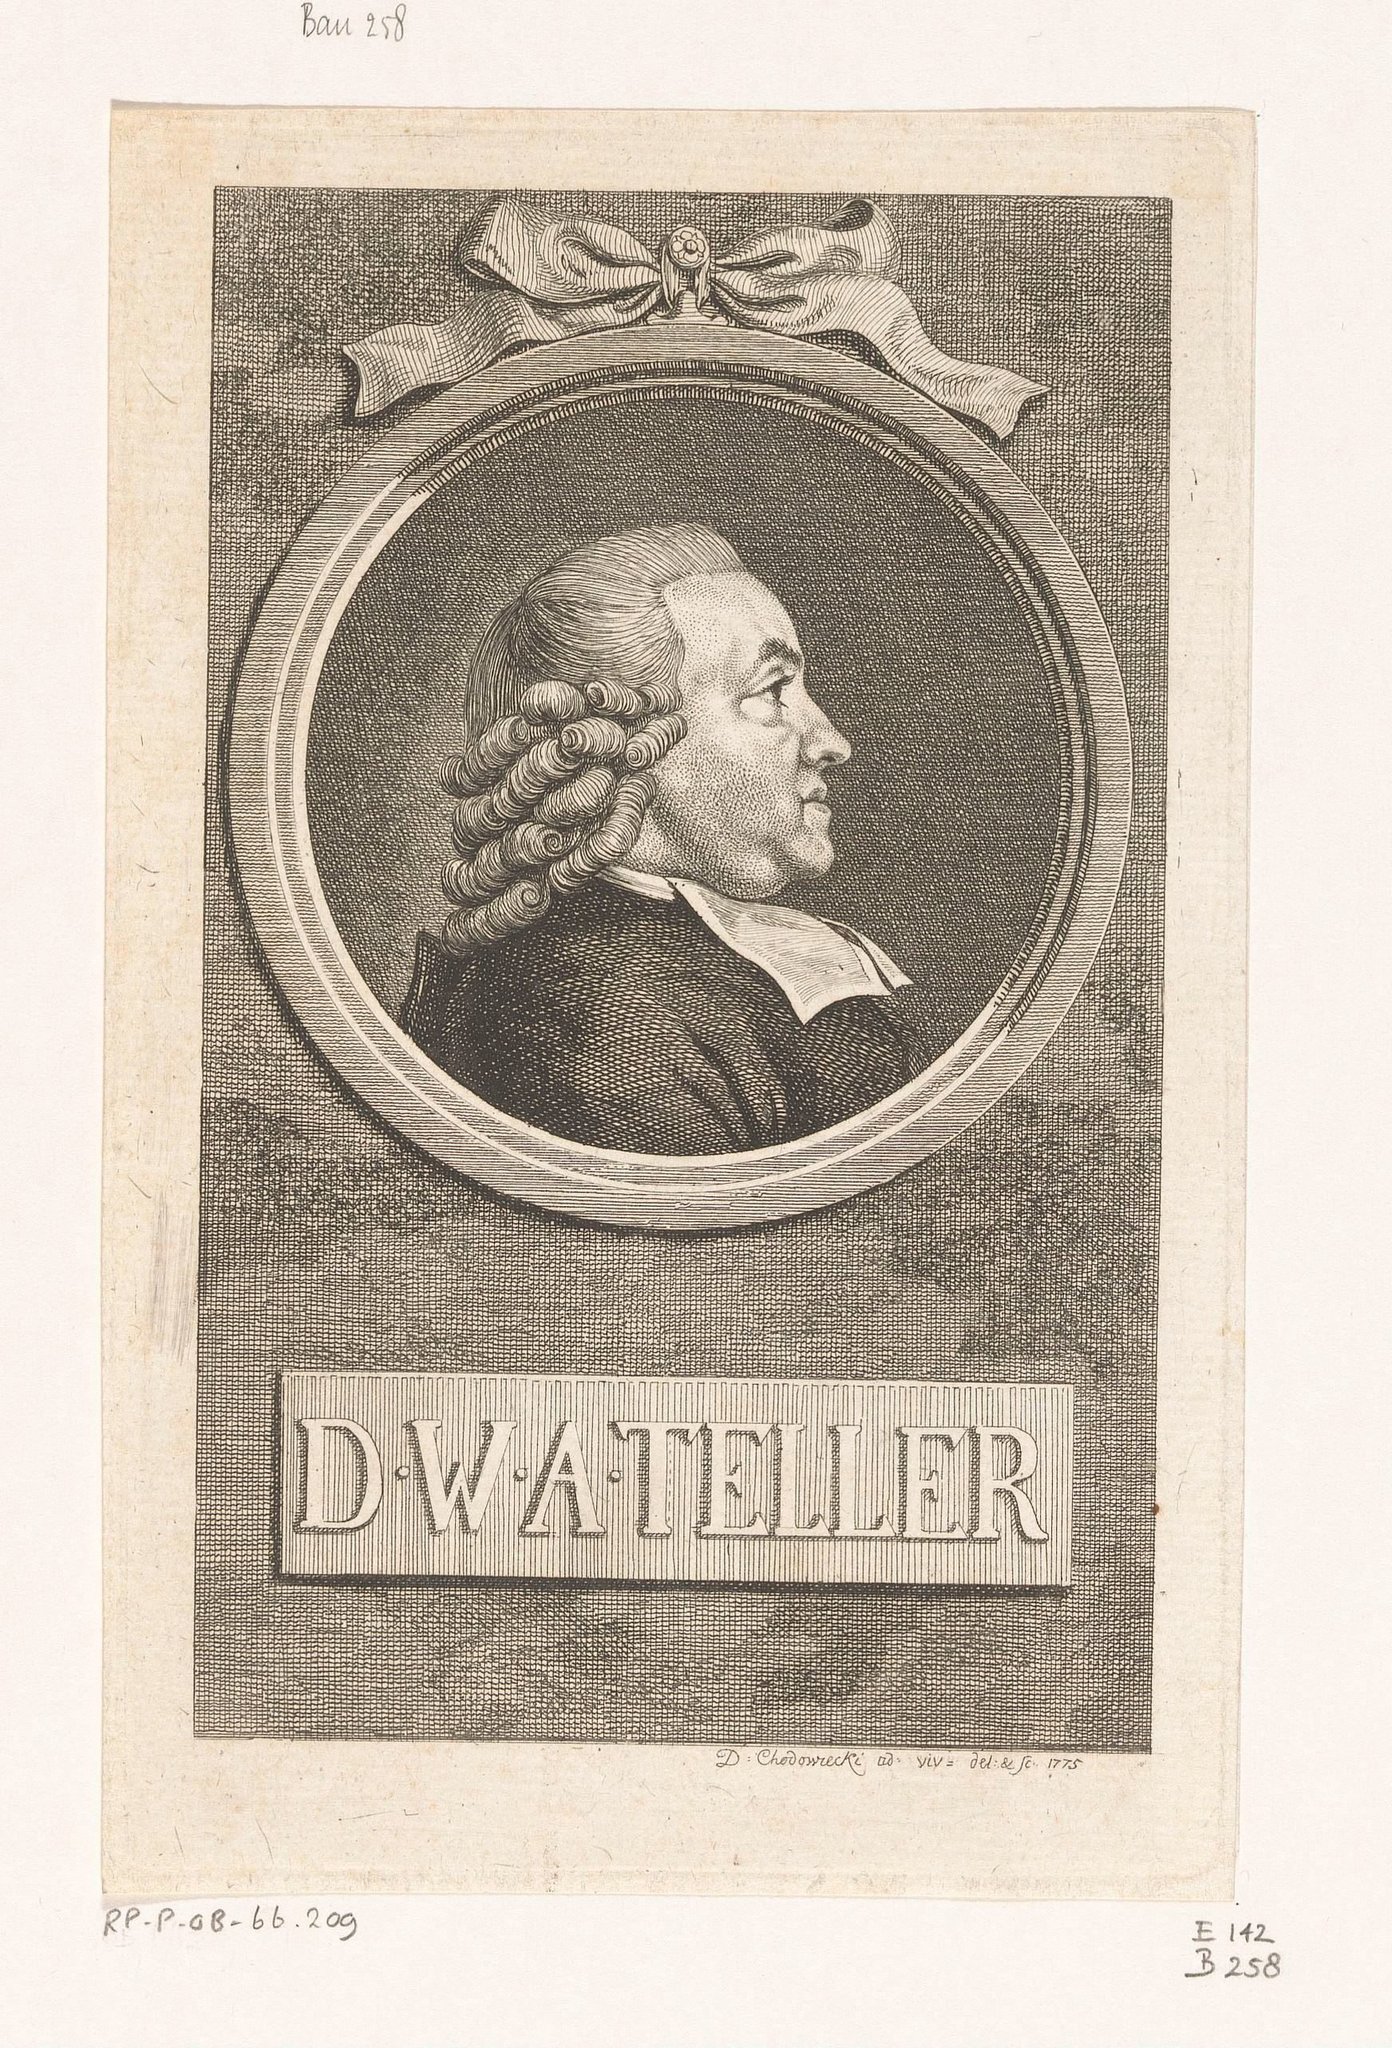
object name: print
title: Portret van Wilhelm Abraham Teller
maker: daniel nikolaus chodowiecki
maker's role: draughtsman, print maker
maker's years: 1726-1801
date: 1775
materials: paper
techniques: etching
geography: berlin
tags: historical persons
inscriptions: collector's mark: Lugt 240, collector's mark: Lugt 700, inscription: ‘C - 12’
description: Prent ook gebruikt in: Allgemeine deutsche Bibliothek. Berlijn en Stettin: Friedrich Nicolai, dl. 28, eerste stuk.